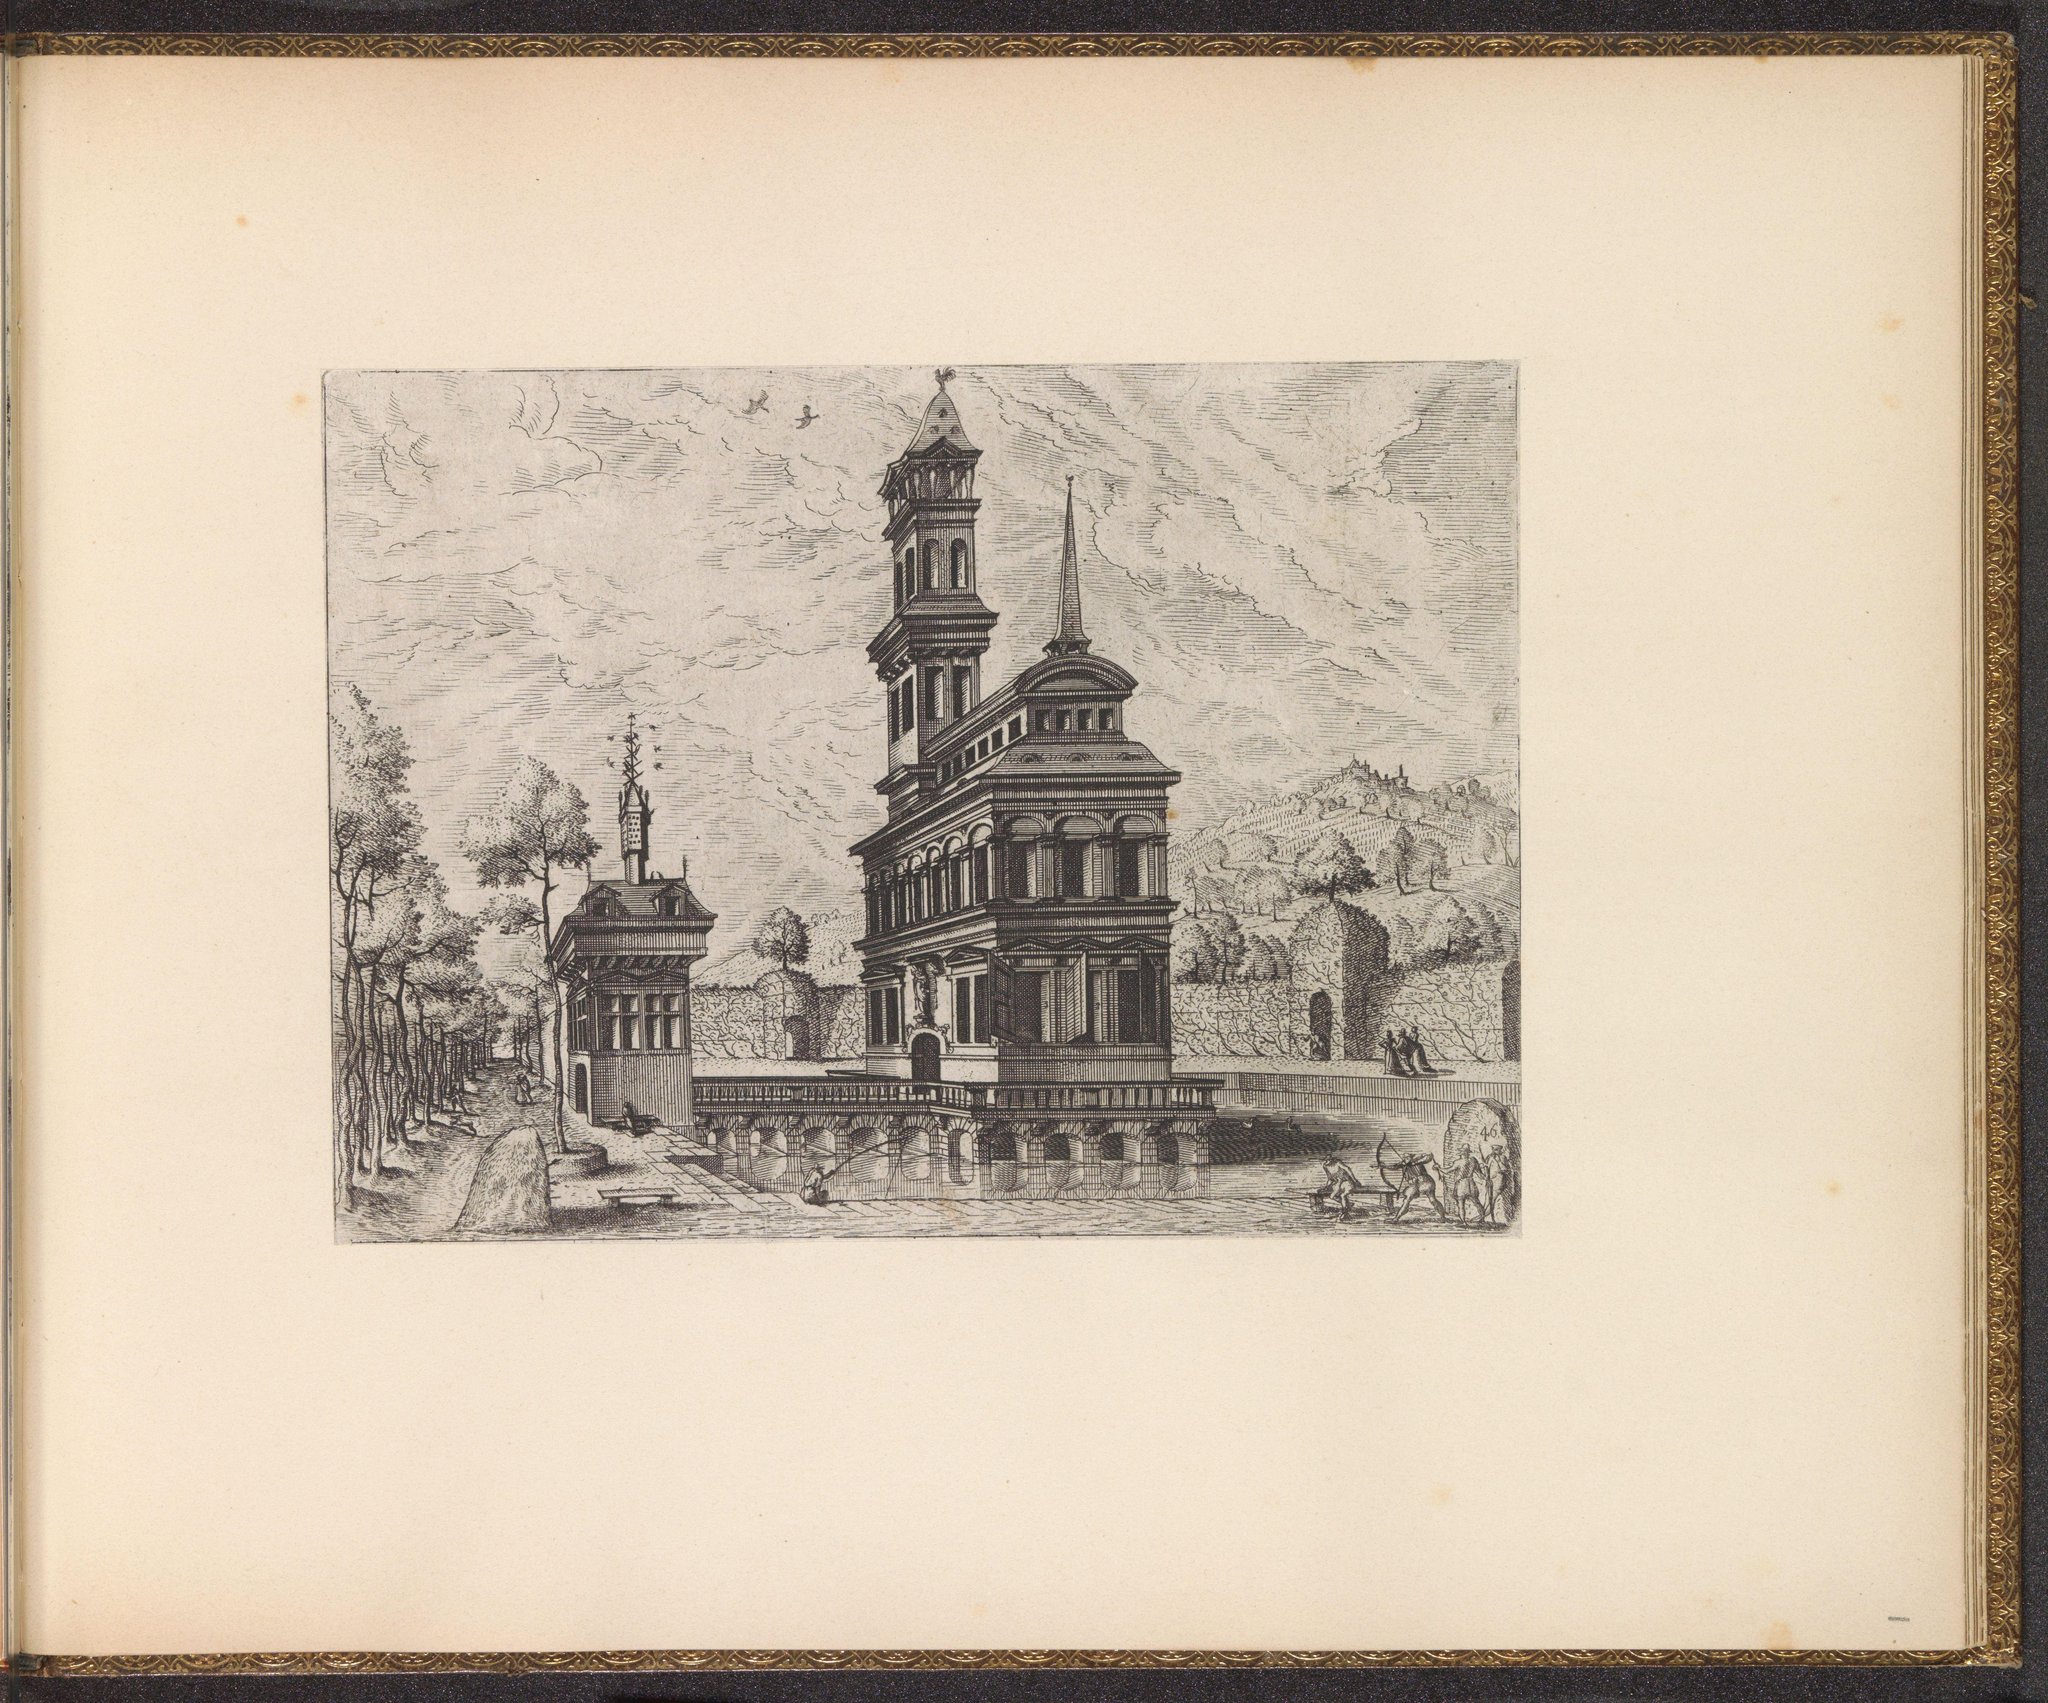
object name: ornament print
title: Architectuurperspectieven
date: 1601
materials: paper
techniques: etching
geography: antwerp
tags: garden, gate, entrance, shooting with bow and arrow, archery (~ games of skill)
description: Monumentaal tuinpaviljoen, gelegen in een bassin, met een toegangspoort en een brug. Links loopt een laan met bomen, op de achtergrond liggen berceau (bogengangen). Op de voorgrond zit een man te vissen en spelen vier mensen een handboogwedstrijd. De prent maakt deel uit van een album.